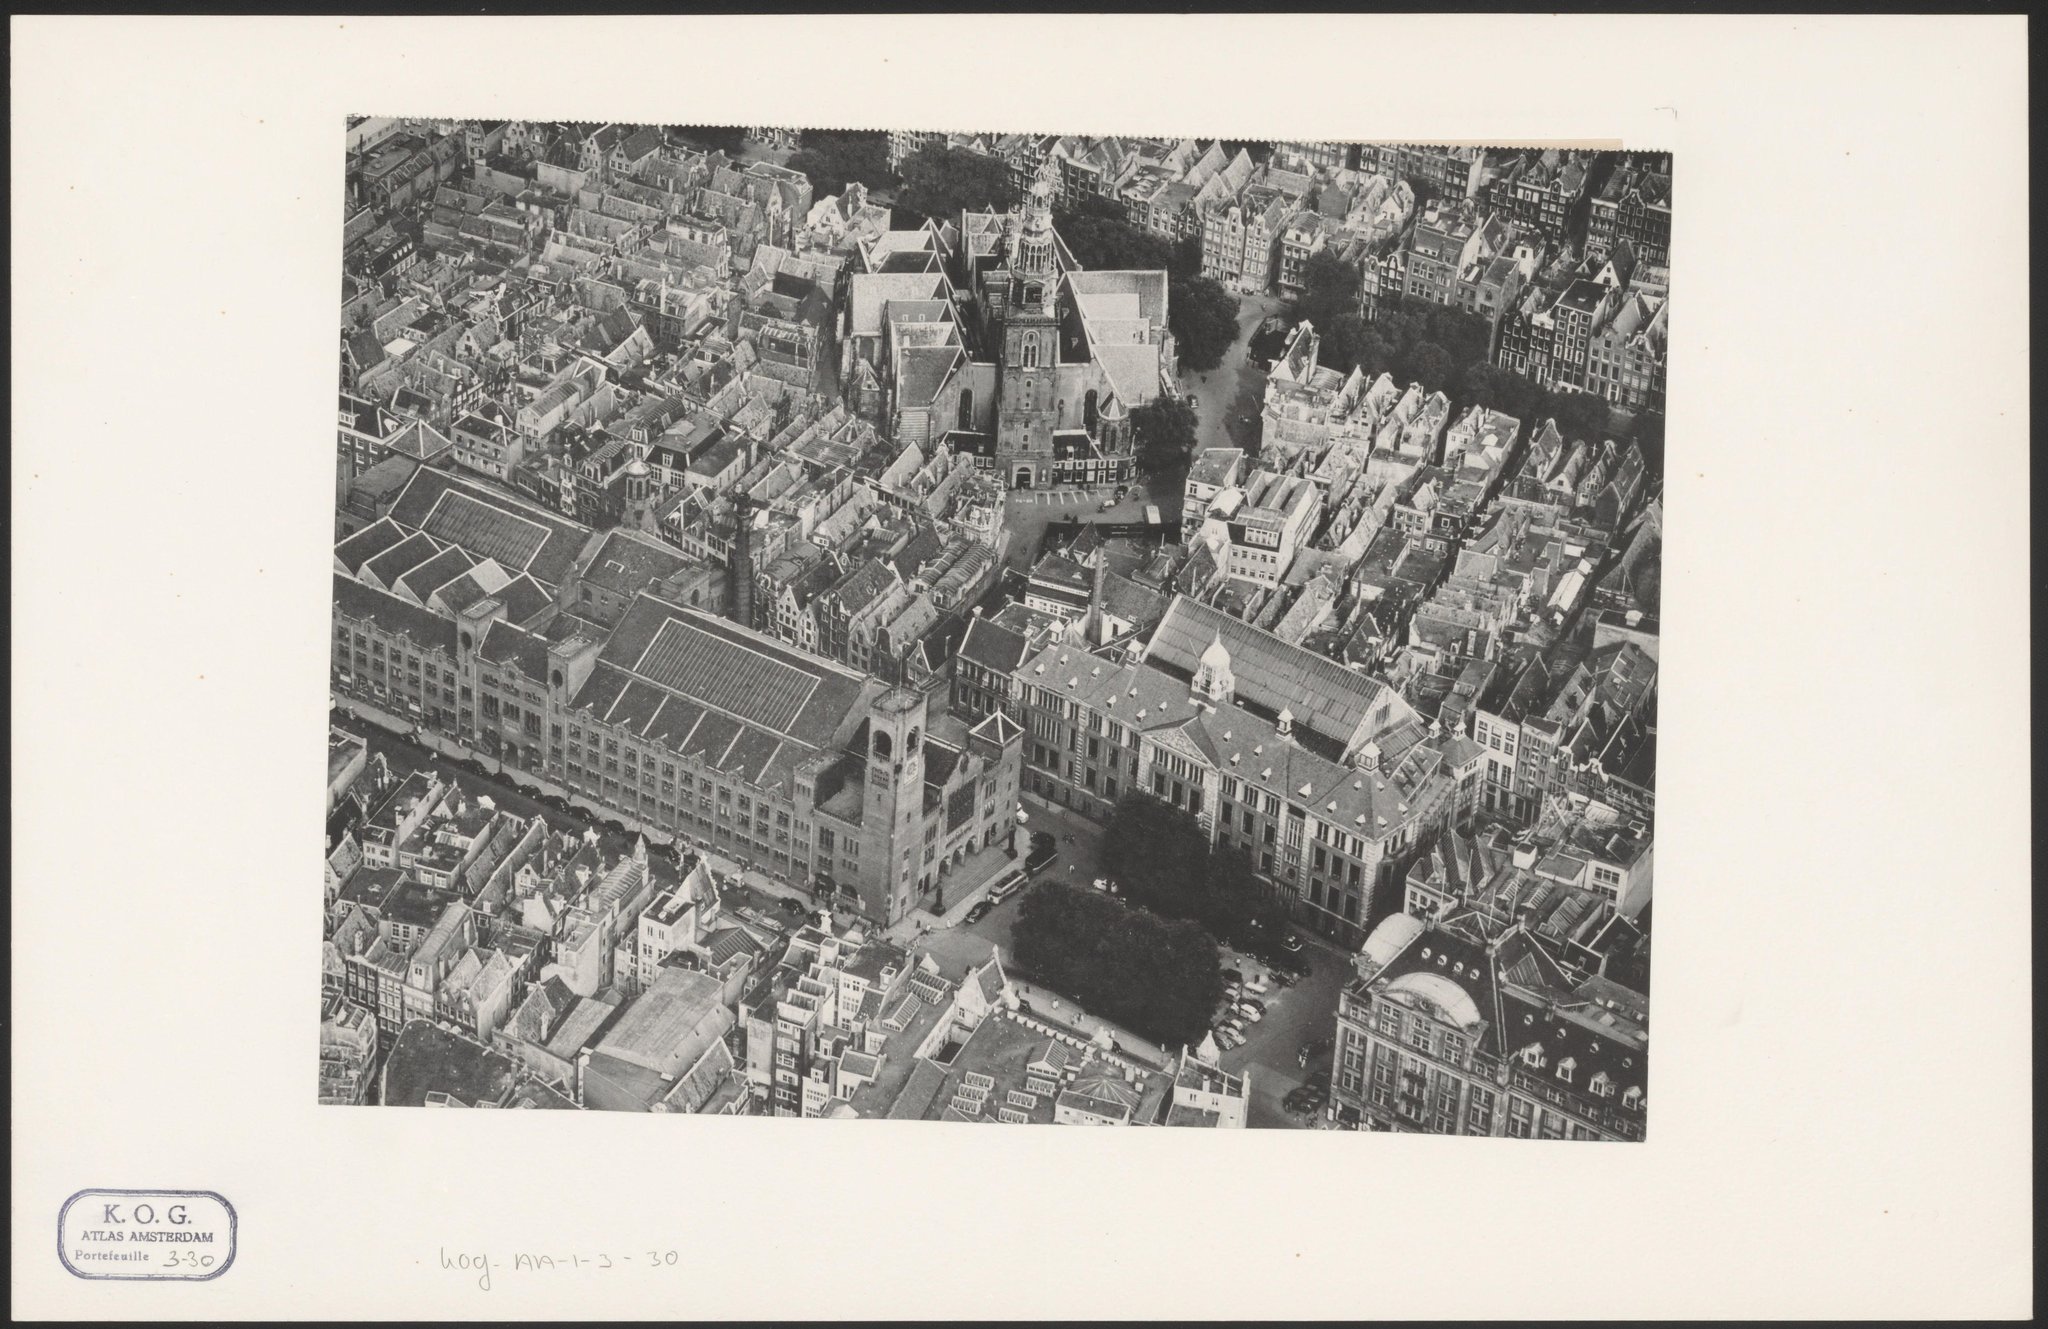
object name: photomechanical print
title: Gezicht op de Beurs van Berlage en de Effectenbeurs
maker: Anonymous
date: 1903-1950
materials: paper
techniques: autotype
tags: stock exchange, stock-market, market-hall, prospect of city, town panorama, silhouette of city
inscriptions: collector's mark: ‘3-30’ Lugt 1641b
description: Onderwerpsrubriek binnen de Atlas Amsterdam: Panorama's en verzamelprenten.